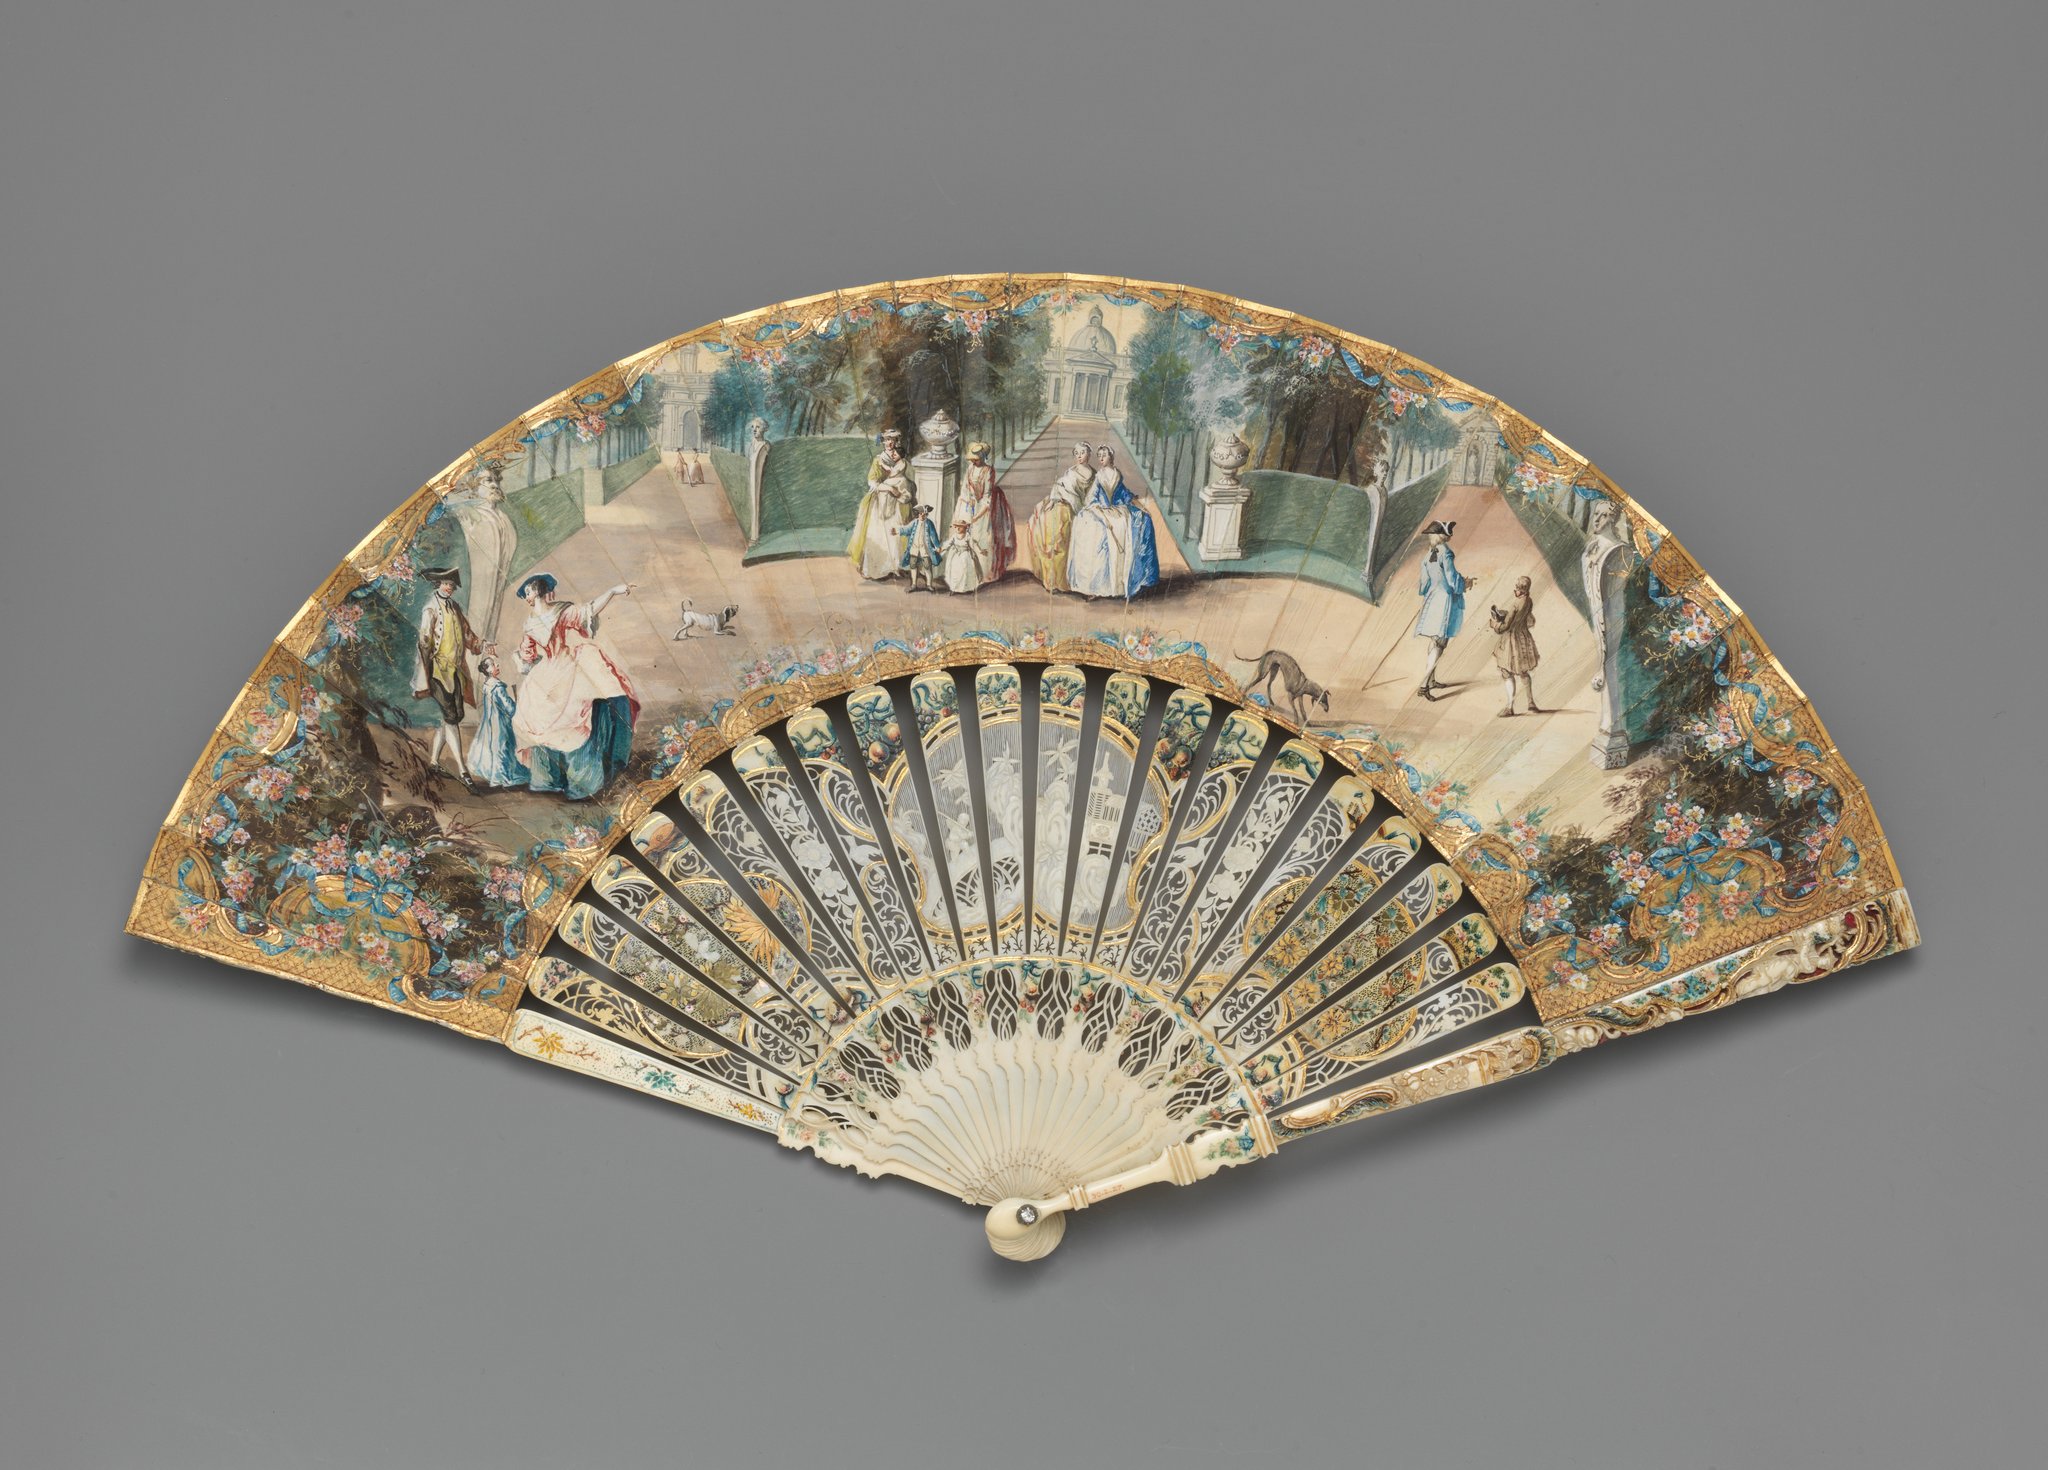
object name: fan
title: Folding Fan with Representation of the Gardens at Chiswick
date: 1757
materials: glass, ivory, metal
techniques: carving, gilding, painting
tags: gardens,men,women,dogs,trees